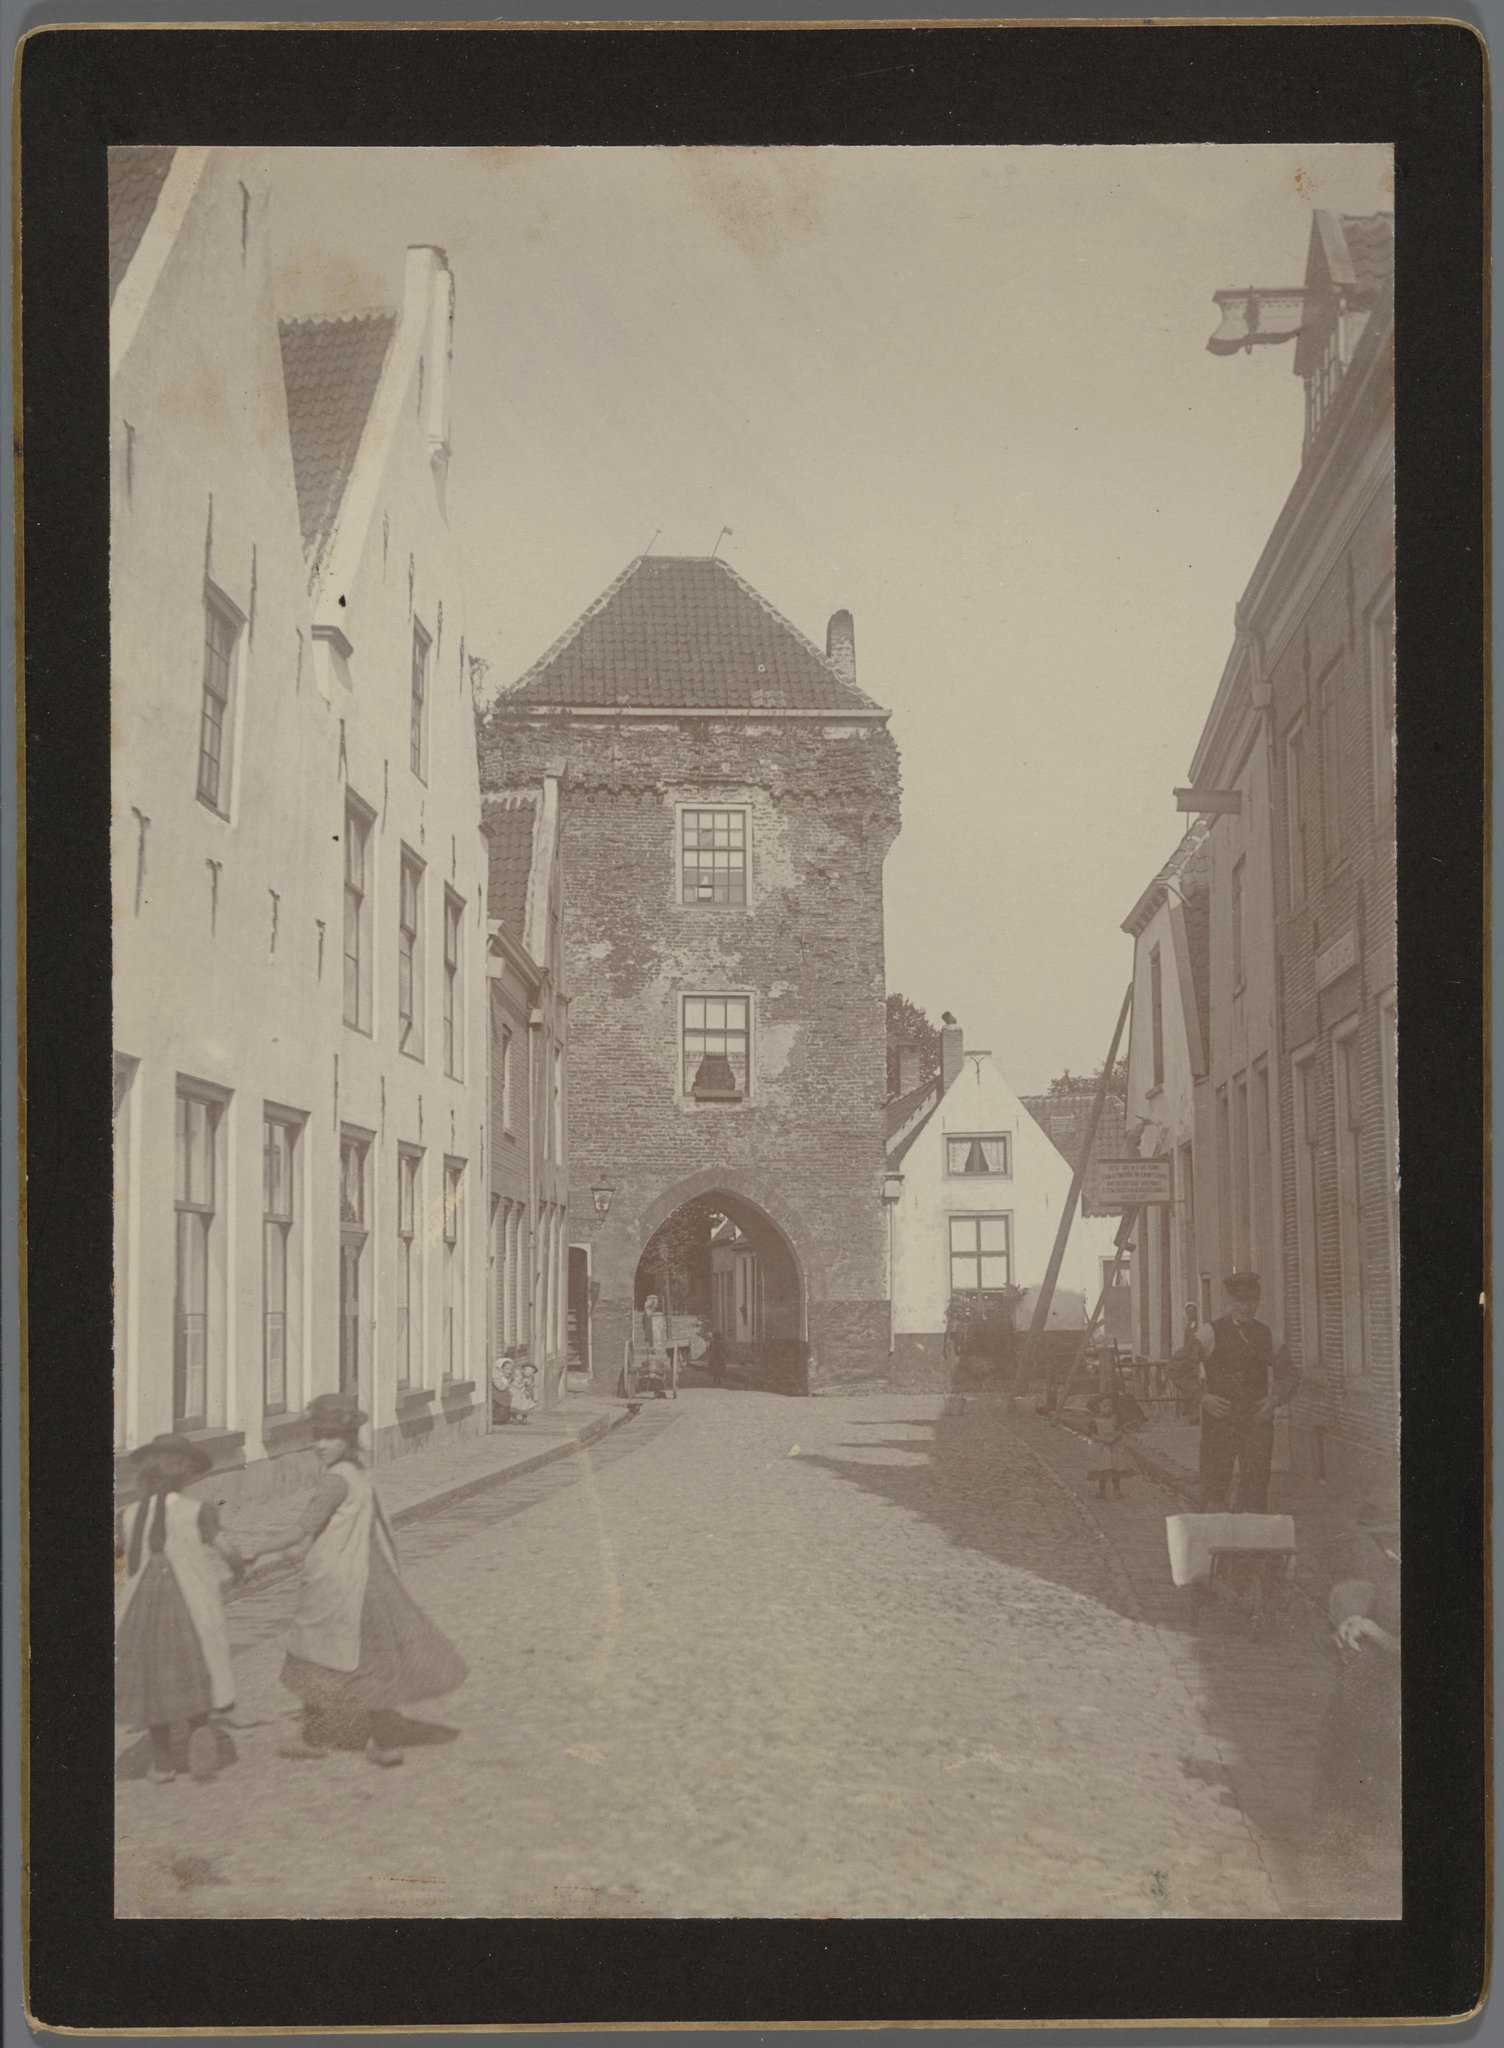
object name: photograph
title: Gezicht op de Kruisstraat met Dijkpoort te Hattem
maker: cornelia hendrika jonker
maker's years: 1874-1924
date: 1880-1909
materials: cardboard, photographic support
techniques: collodion silver print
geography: hattem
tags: historical persons, village street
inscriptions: annotation: ‘Hattem/ C’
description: Gezicht op de Kruisstraat in Hattem met de Dijkpoort vóór de restauratie door architect P.J.H. Cuypers in 1909.